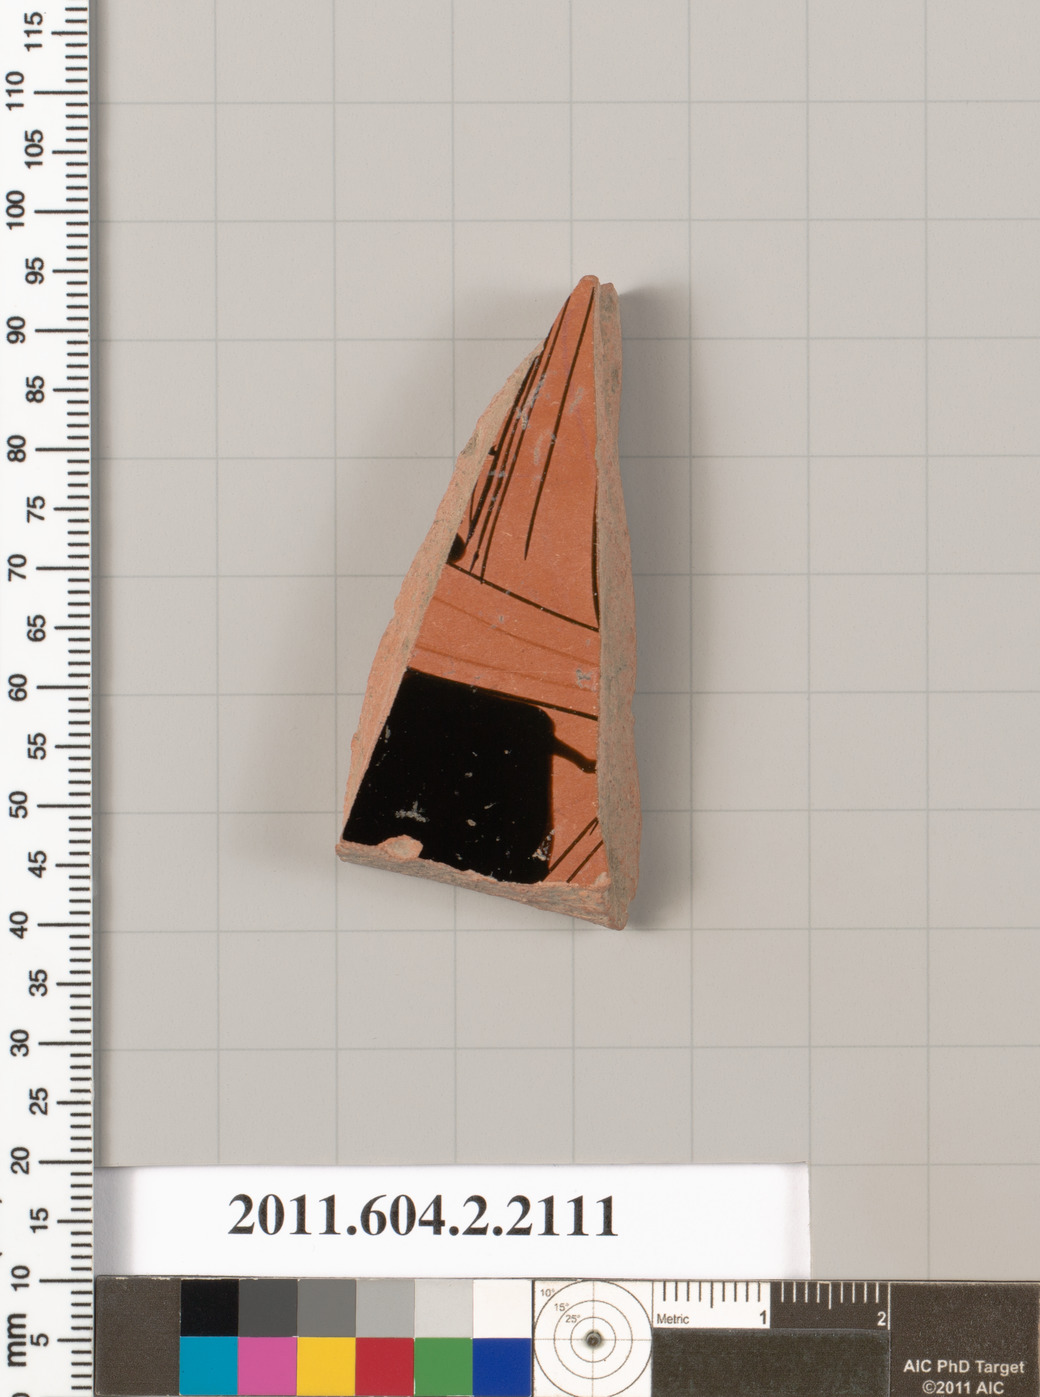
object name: krater fragment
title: Terracotta fragment of a krater (bowl for mixing wine and water)?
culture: greek, attic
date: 450-426 BCE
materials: terracotta